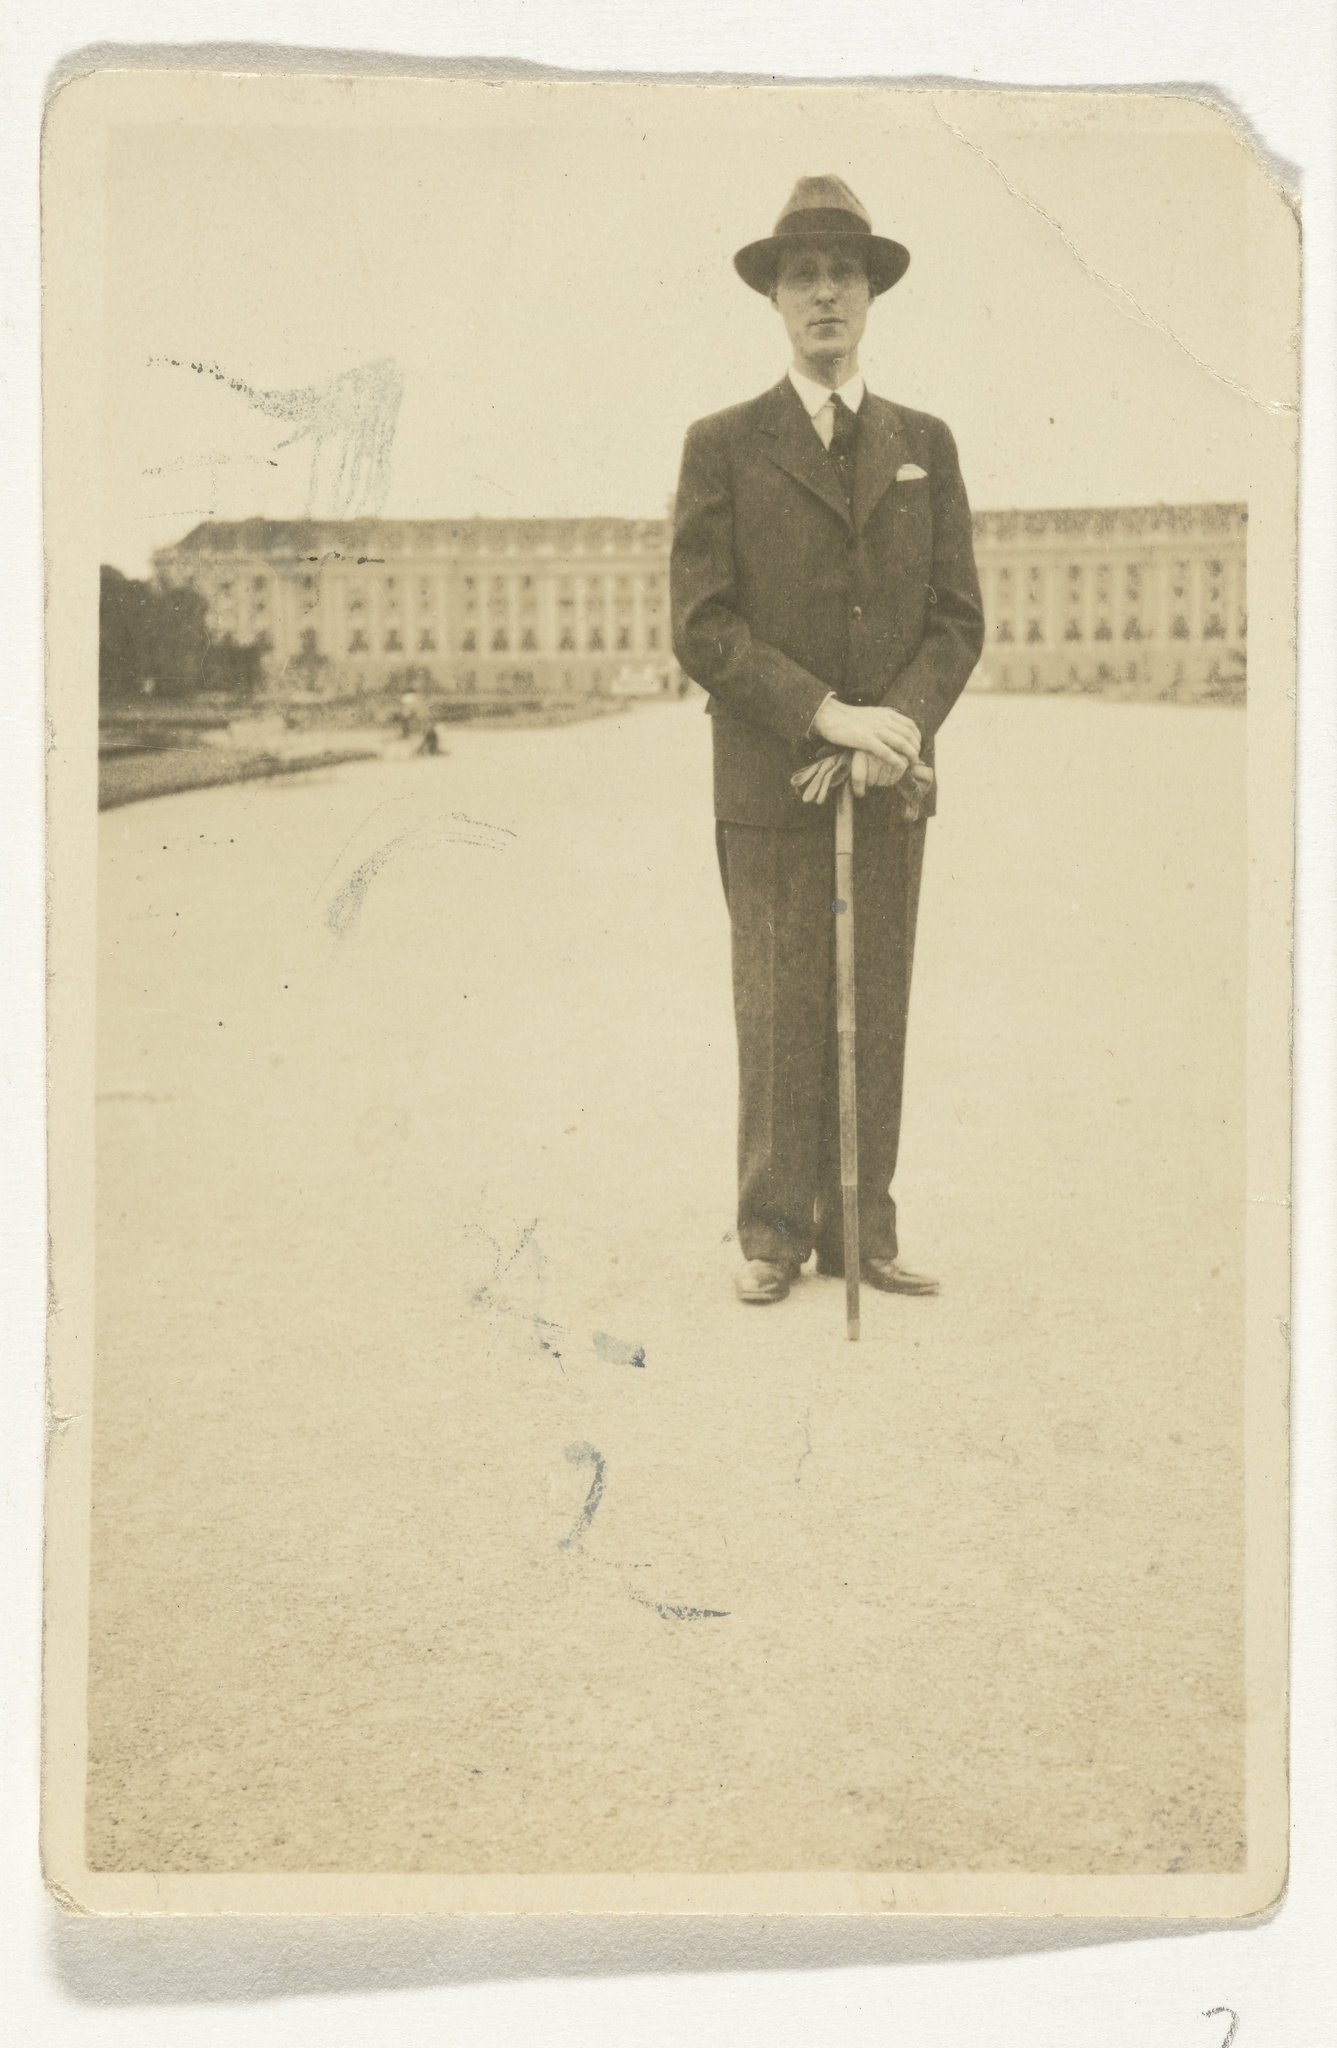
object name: photograph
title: Portret van Carel Willink met wandelstok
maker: Anonymous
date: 1930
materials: cardboard, paper, photographic support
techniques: gelatin silver print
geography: netherlands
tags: amsterdam, print maker, draughtsman, carel willink, portrait, self-portrait of artist